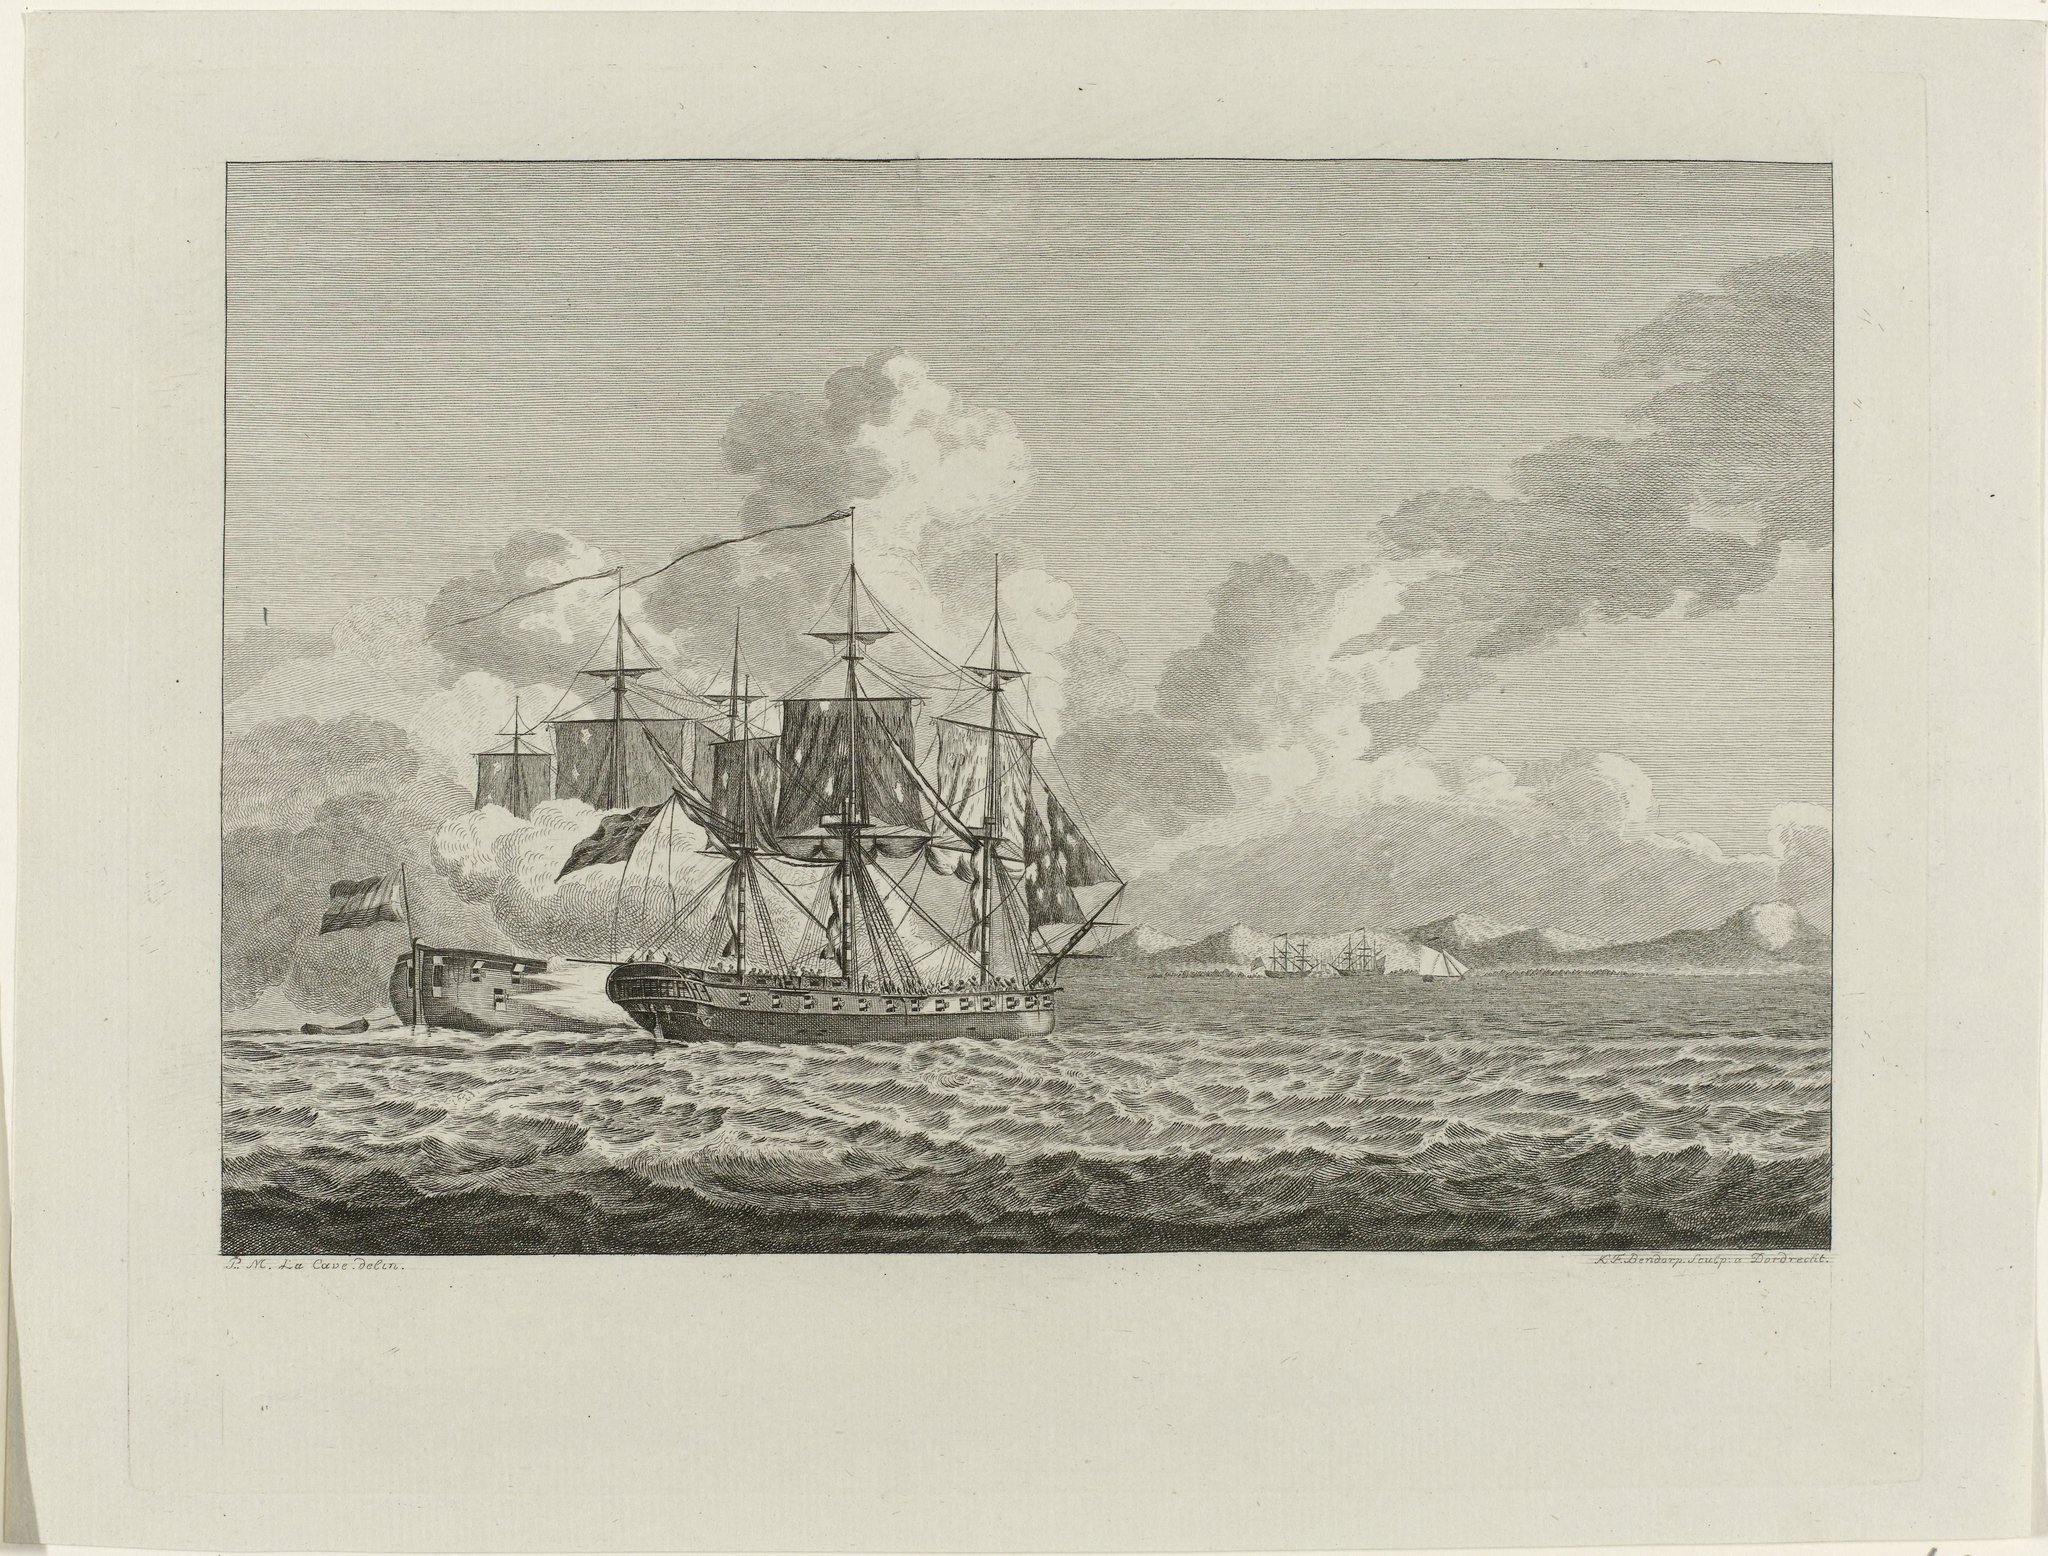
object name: print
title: Gevecht tussen Hoekerschip Vrouw Machtelyna en Engels fregat Diamant voor de haven van Curaçao, 1782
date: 1782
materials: paper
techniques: engraving, etching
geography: dordrecht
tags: battle (+ naval force), fourth anglo-dutch war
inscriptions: collector's mark: Lugt 2228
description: Het Nederlandse gewapende hoekerschip de Vrouw Machtelyna in gevecht met het Engelse fregat de Diamant, voor de haven van Curaçao, 16 juni 1782. Onderdeel van een serie van drie platen van het gevecht van het hoekerschip Vrouw Machtelyna met het Engelse fregat Diamant voor de haven van Curaçao op 16 juni 1782.